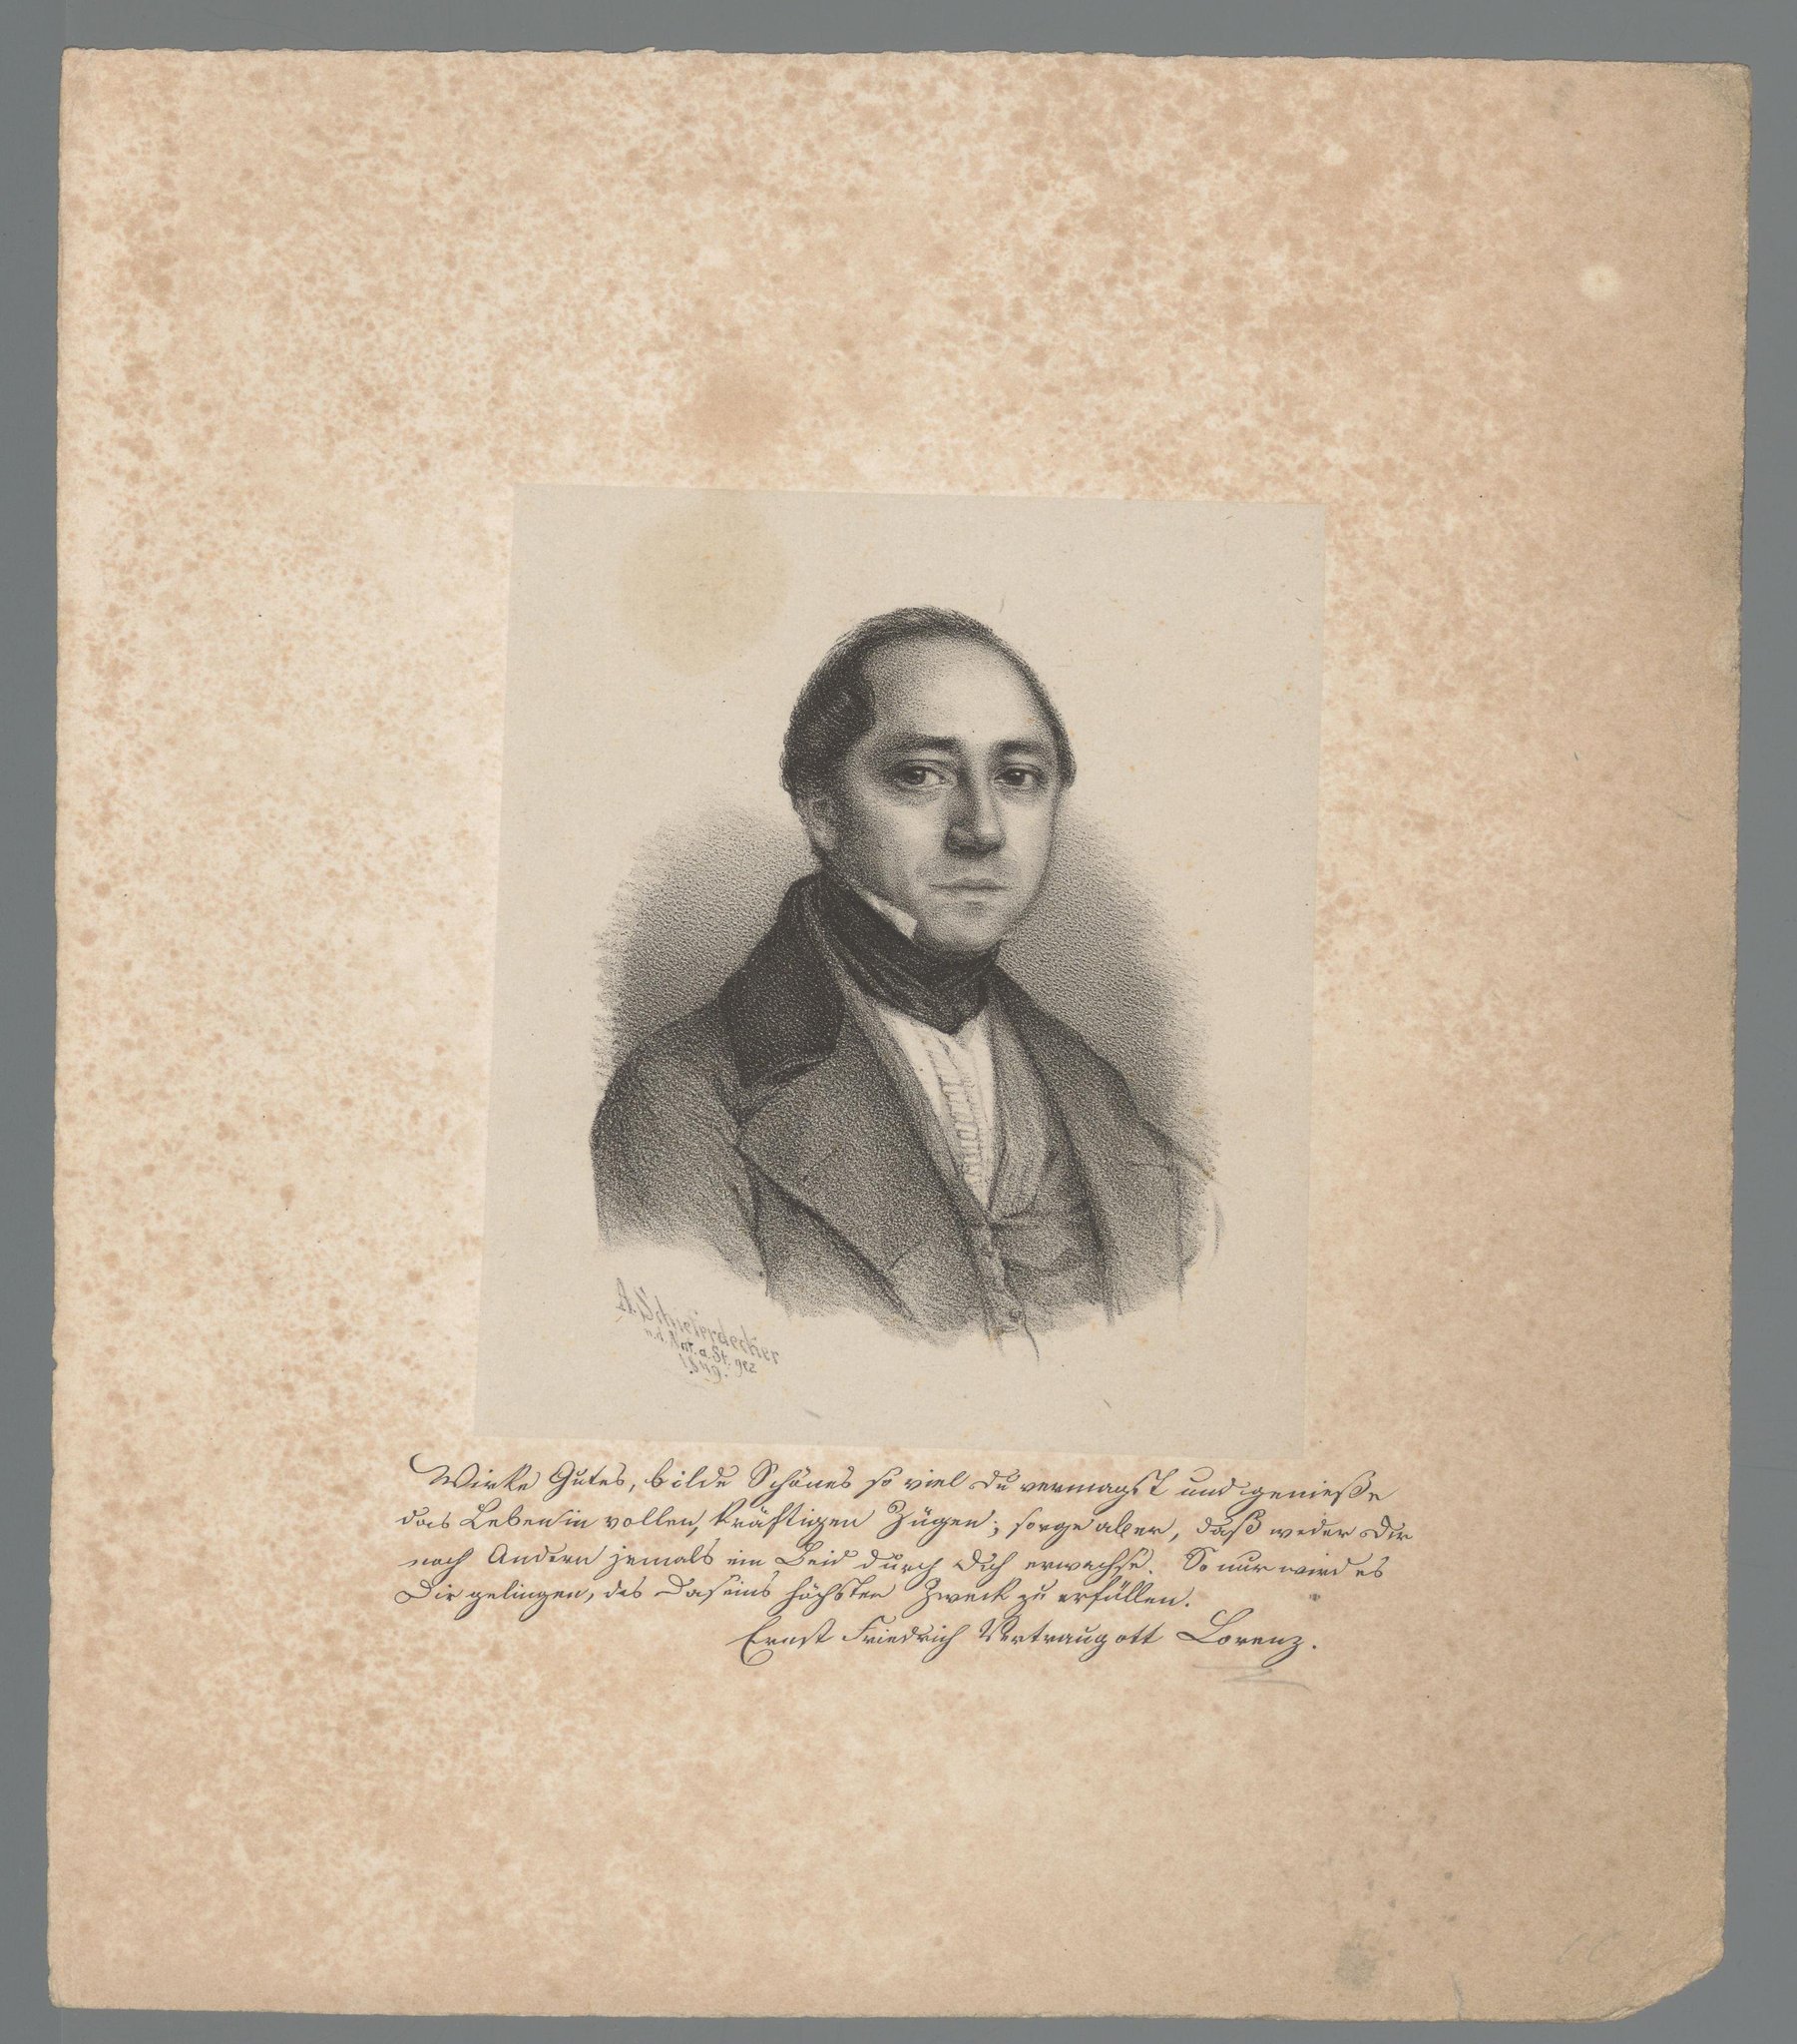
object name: print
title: Portret van Ernst Friedrich Vertraugott Lorenz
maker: christian karl august schieferdecker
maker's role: print maker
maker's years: 1823-1878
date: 1849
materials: paper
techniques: lithograph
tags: historical persons not known by name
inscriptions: collector's mark: Lugt 2228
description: Portret van een verder onbekende man met de naam Ernst Friedrich Vertraugott Lorenz.